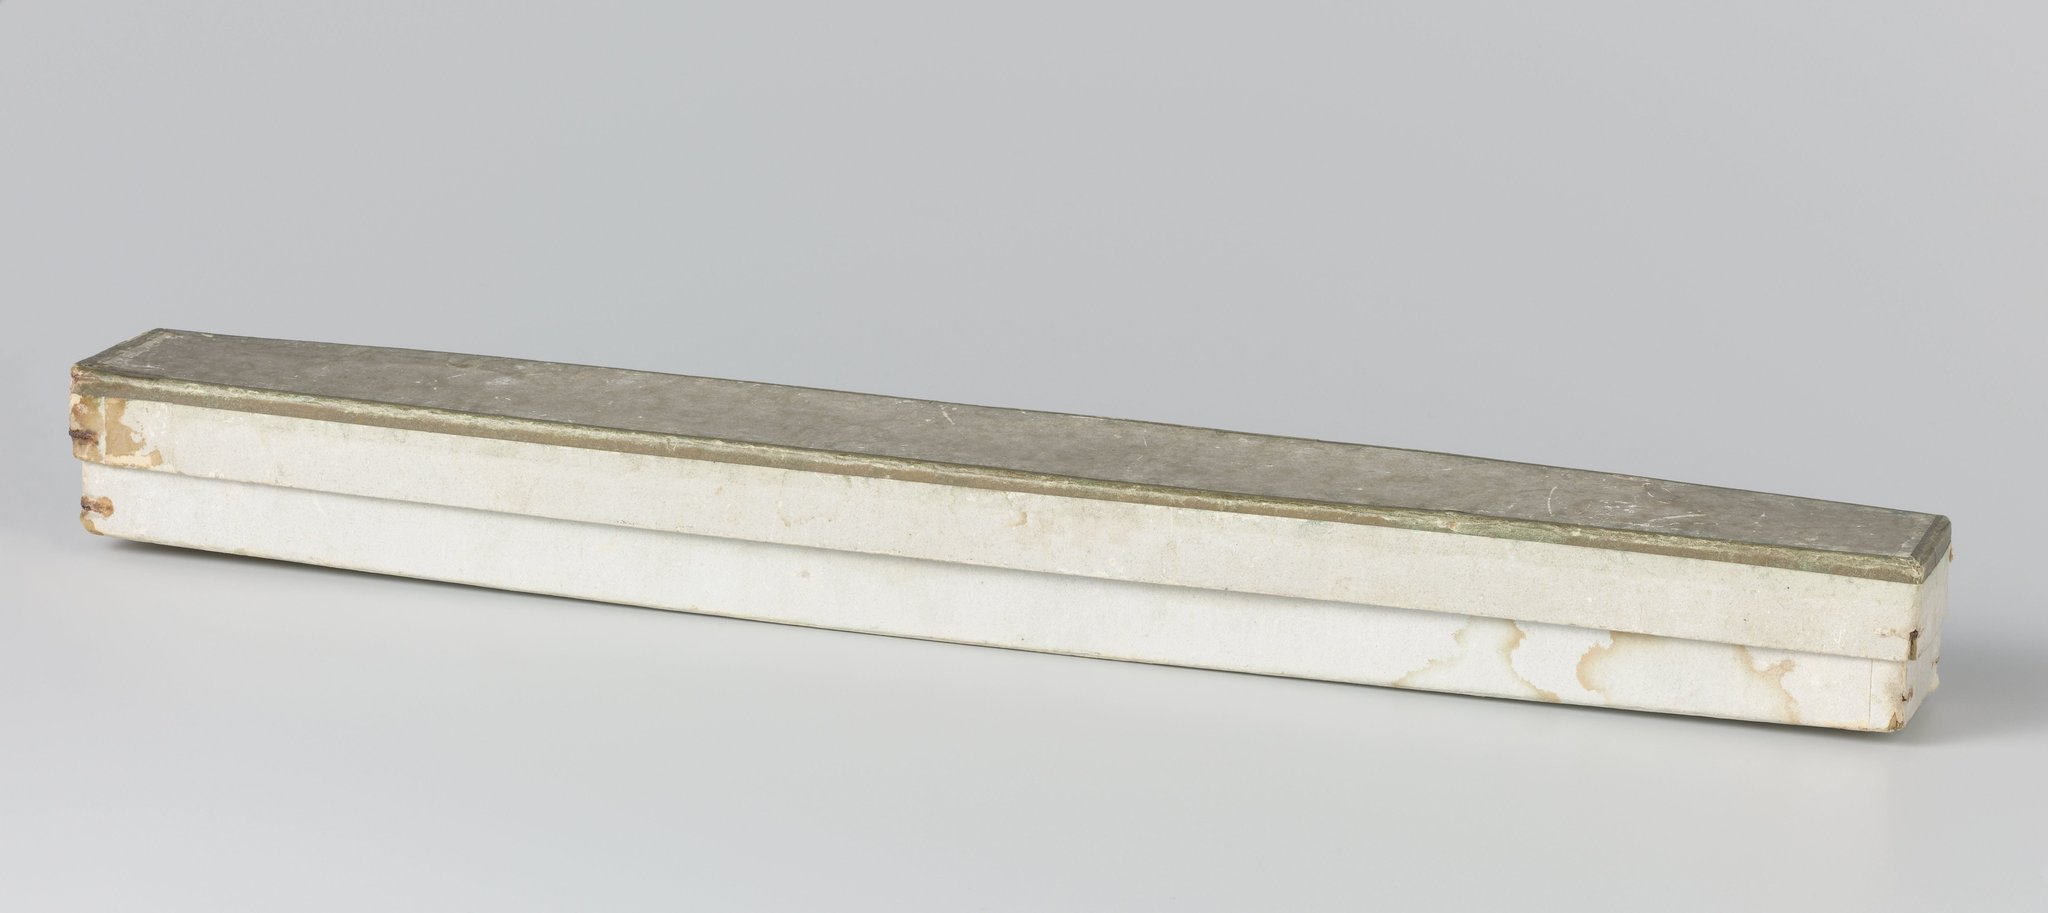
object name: waaierdoos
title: Rechthoekige waaierdoos van strokarton, bovenop deksel beplakt met marmerpapier verder met wit papier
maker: Anonymous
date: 1895-1905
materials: paper, cardboard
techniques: marbling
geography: netherlands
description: Rechthoekige waaierdoos van strokarton, bovenop deksel beplakt met marmerpapier verder met wit papier.